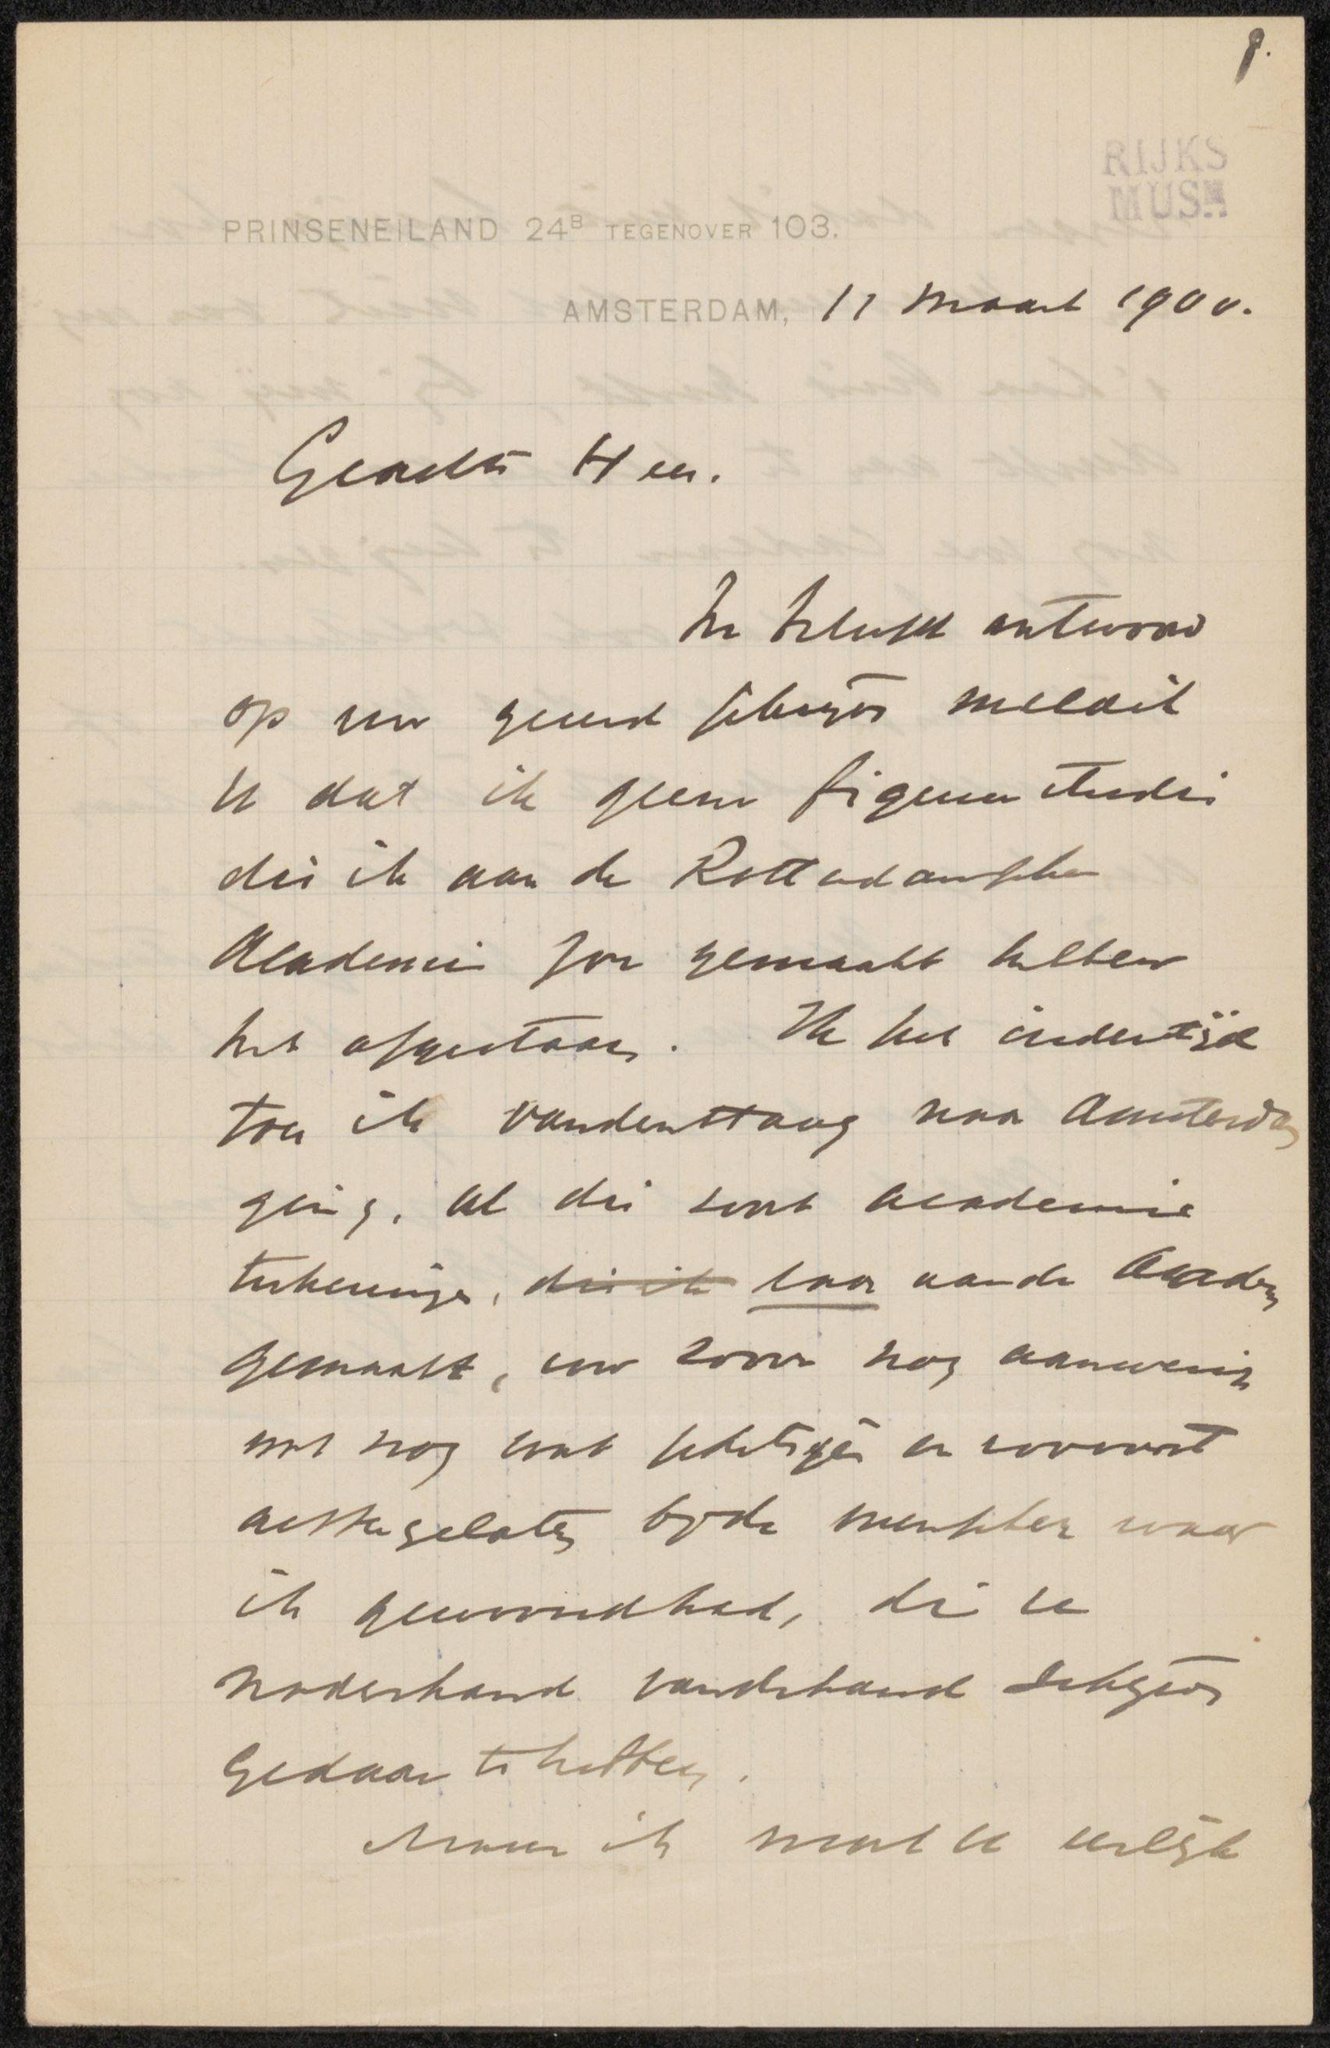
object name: letter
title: Brief aan Pieter Haverkorn van Rijsewijk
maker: george hendrik breitner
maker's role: draughtsman, painter, print maker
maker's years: 1857-1923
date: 1900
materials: ink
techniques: pen, writing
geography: amsterdam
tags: pieter haverkorn van rijsewijk, drawing, education, tuition of the artist (in general), art collecting, money, the hague, rotterdam, amsterdam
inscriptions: address: ‘PRINSENEILAND 24b TEGENOVER 103. AMSTERDAM,’, collector's mark: Lugt 2166